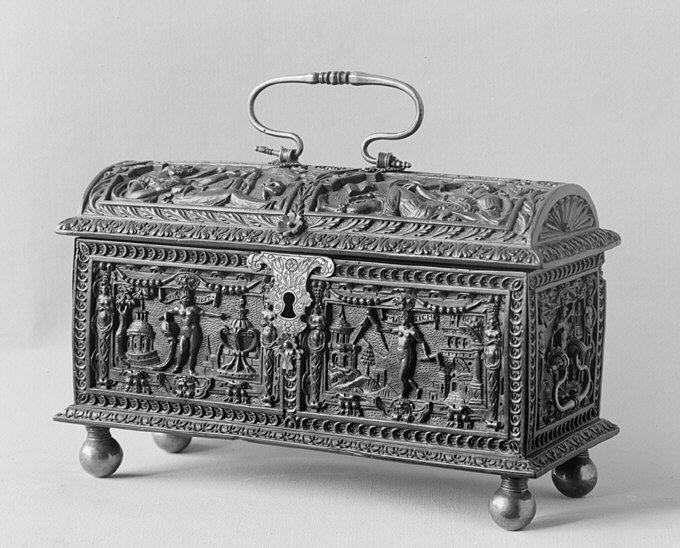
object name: casket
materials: wood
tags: female nudes